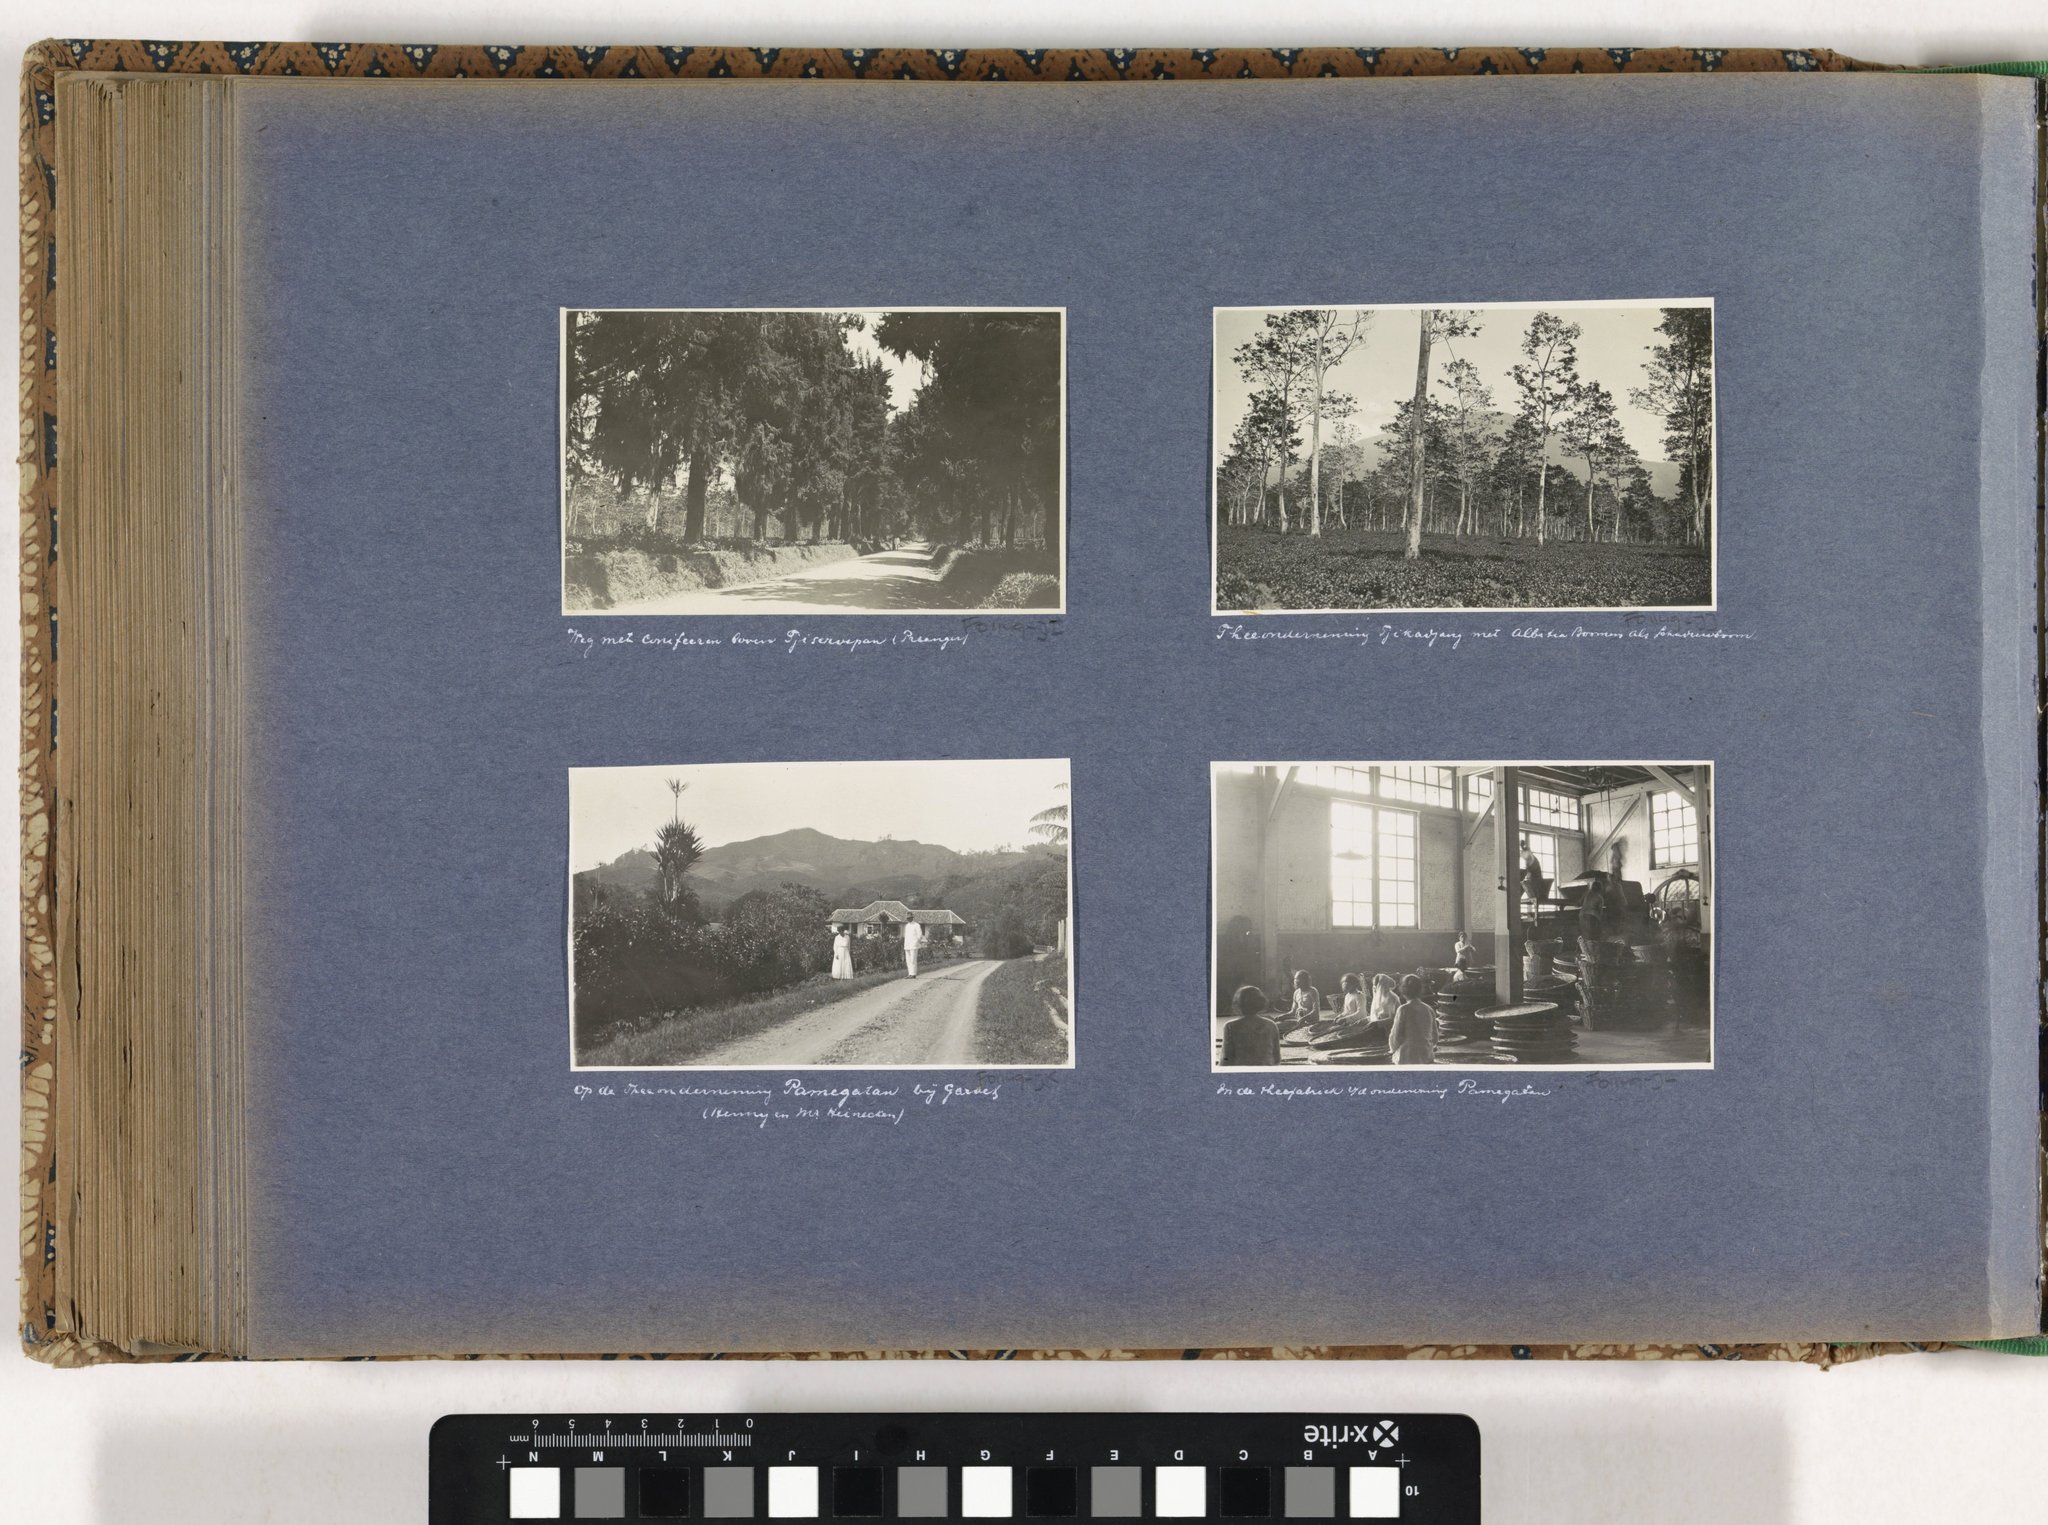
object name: photograph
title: Vrouw en een man, aangeduid als 'Henny en mr. Heinecken', op een weg bij thee-onderneming Pamegatan bij Garut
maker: Anonymous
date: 1900-1920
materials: paper, photographic support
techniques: gelatin silver print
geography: garut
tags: plantation, road, path, java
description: Onderdeel van reisalbum met foto's van bedrijvigheid en bezienswaardigheden op Sumatra en Java en van de reis naar en van Nederlands-Indië.